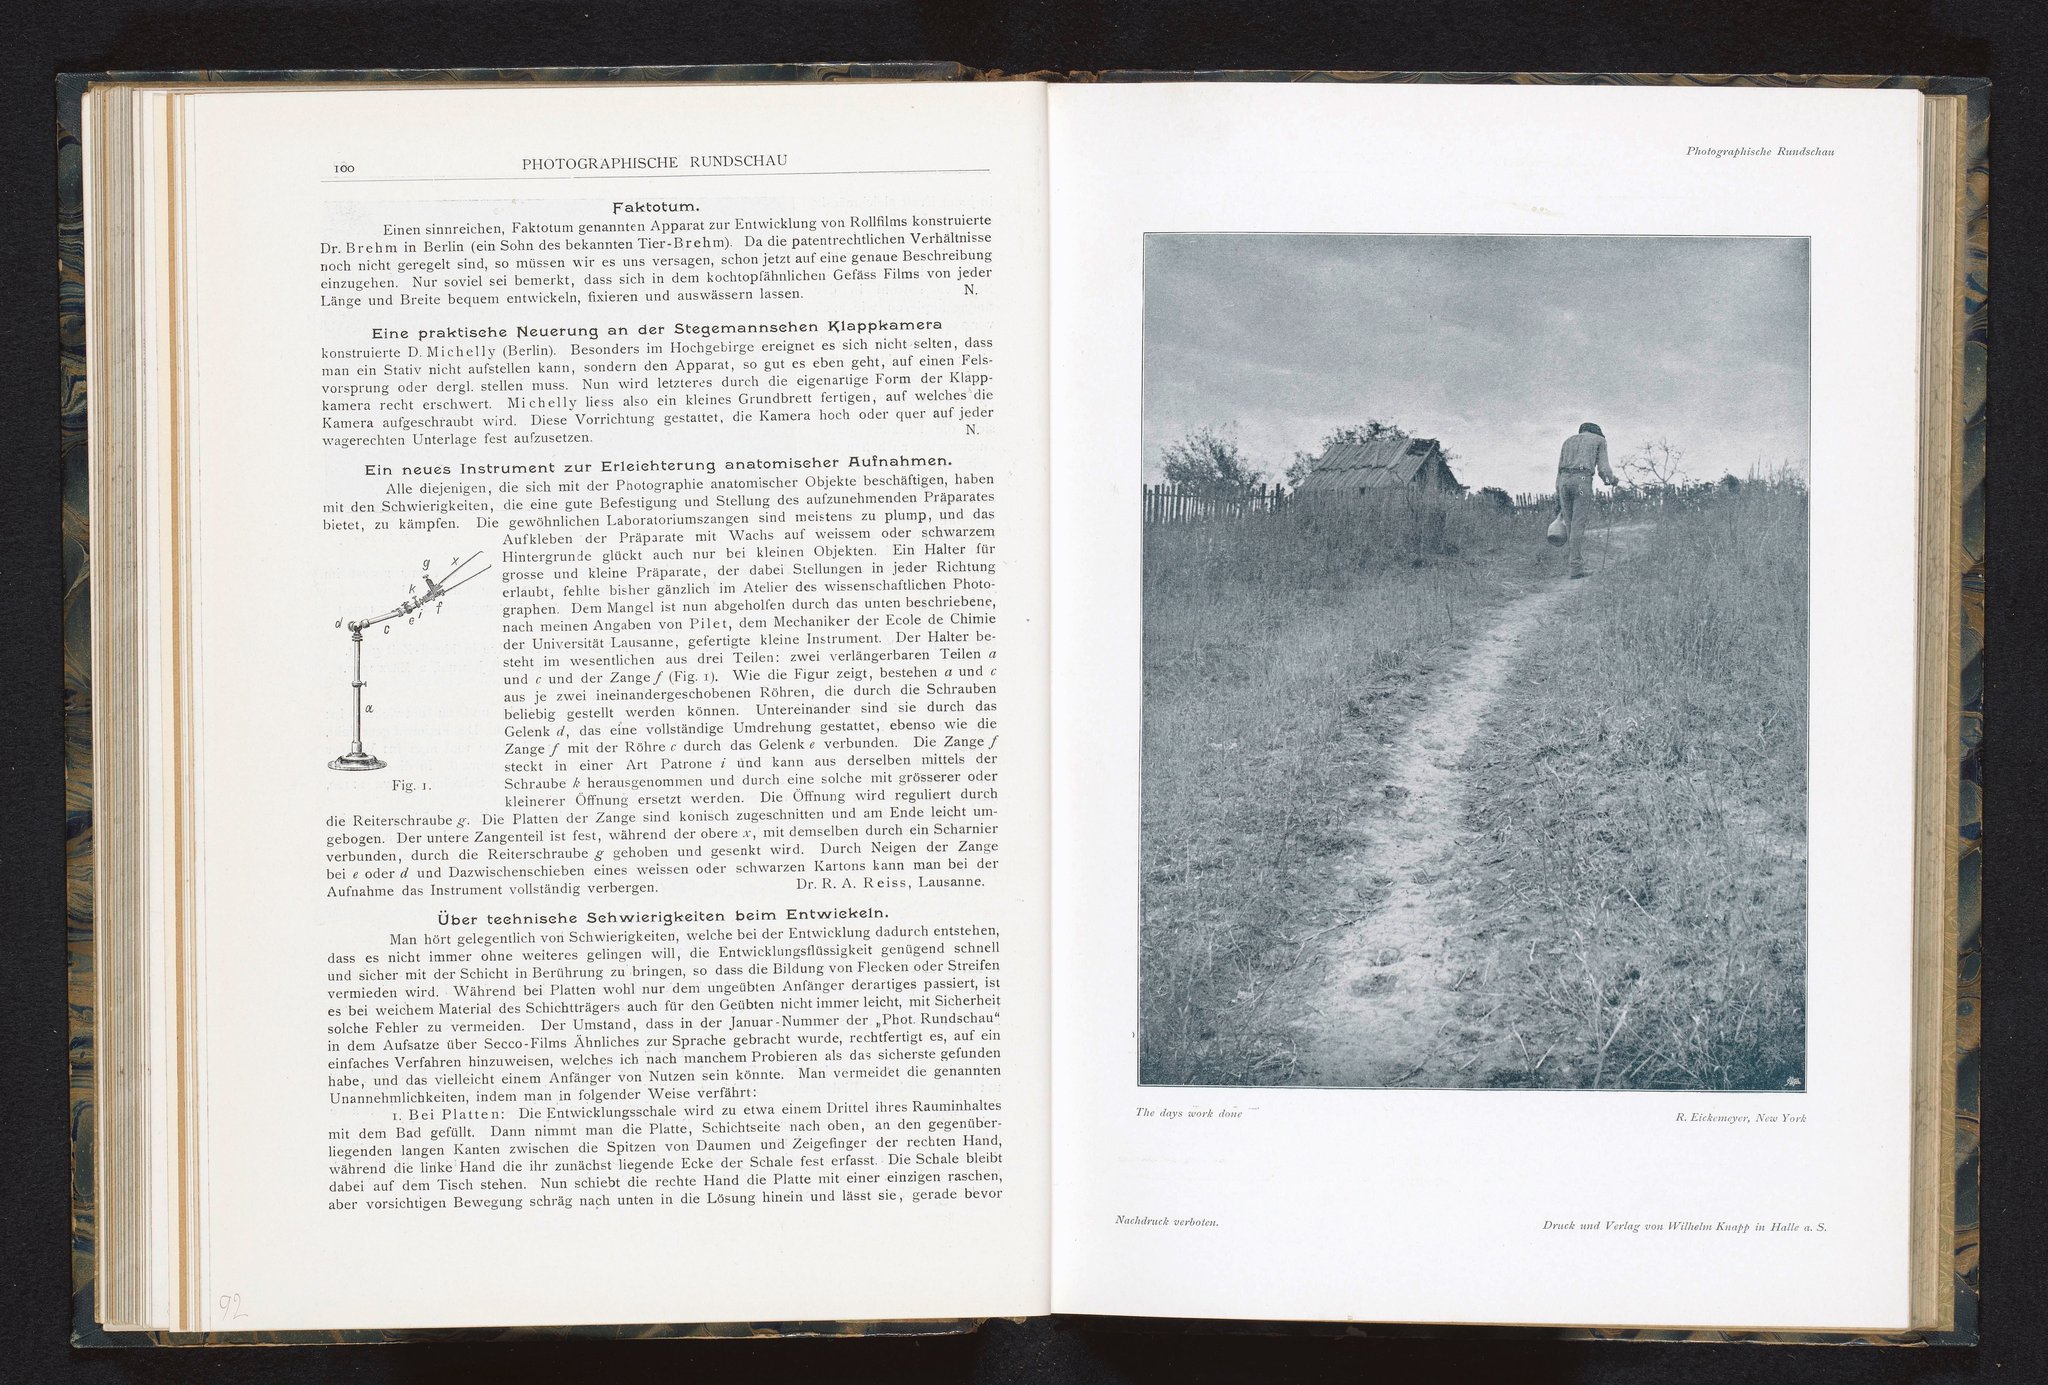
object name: page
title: Gezicht op een onbekende man die een pad omhoog bewandelt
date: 1895-1900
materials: paper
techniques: autotype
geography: halle an der saale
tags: road, path, shed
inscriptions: monogram: ‘[...]’